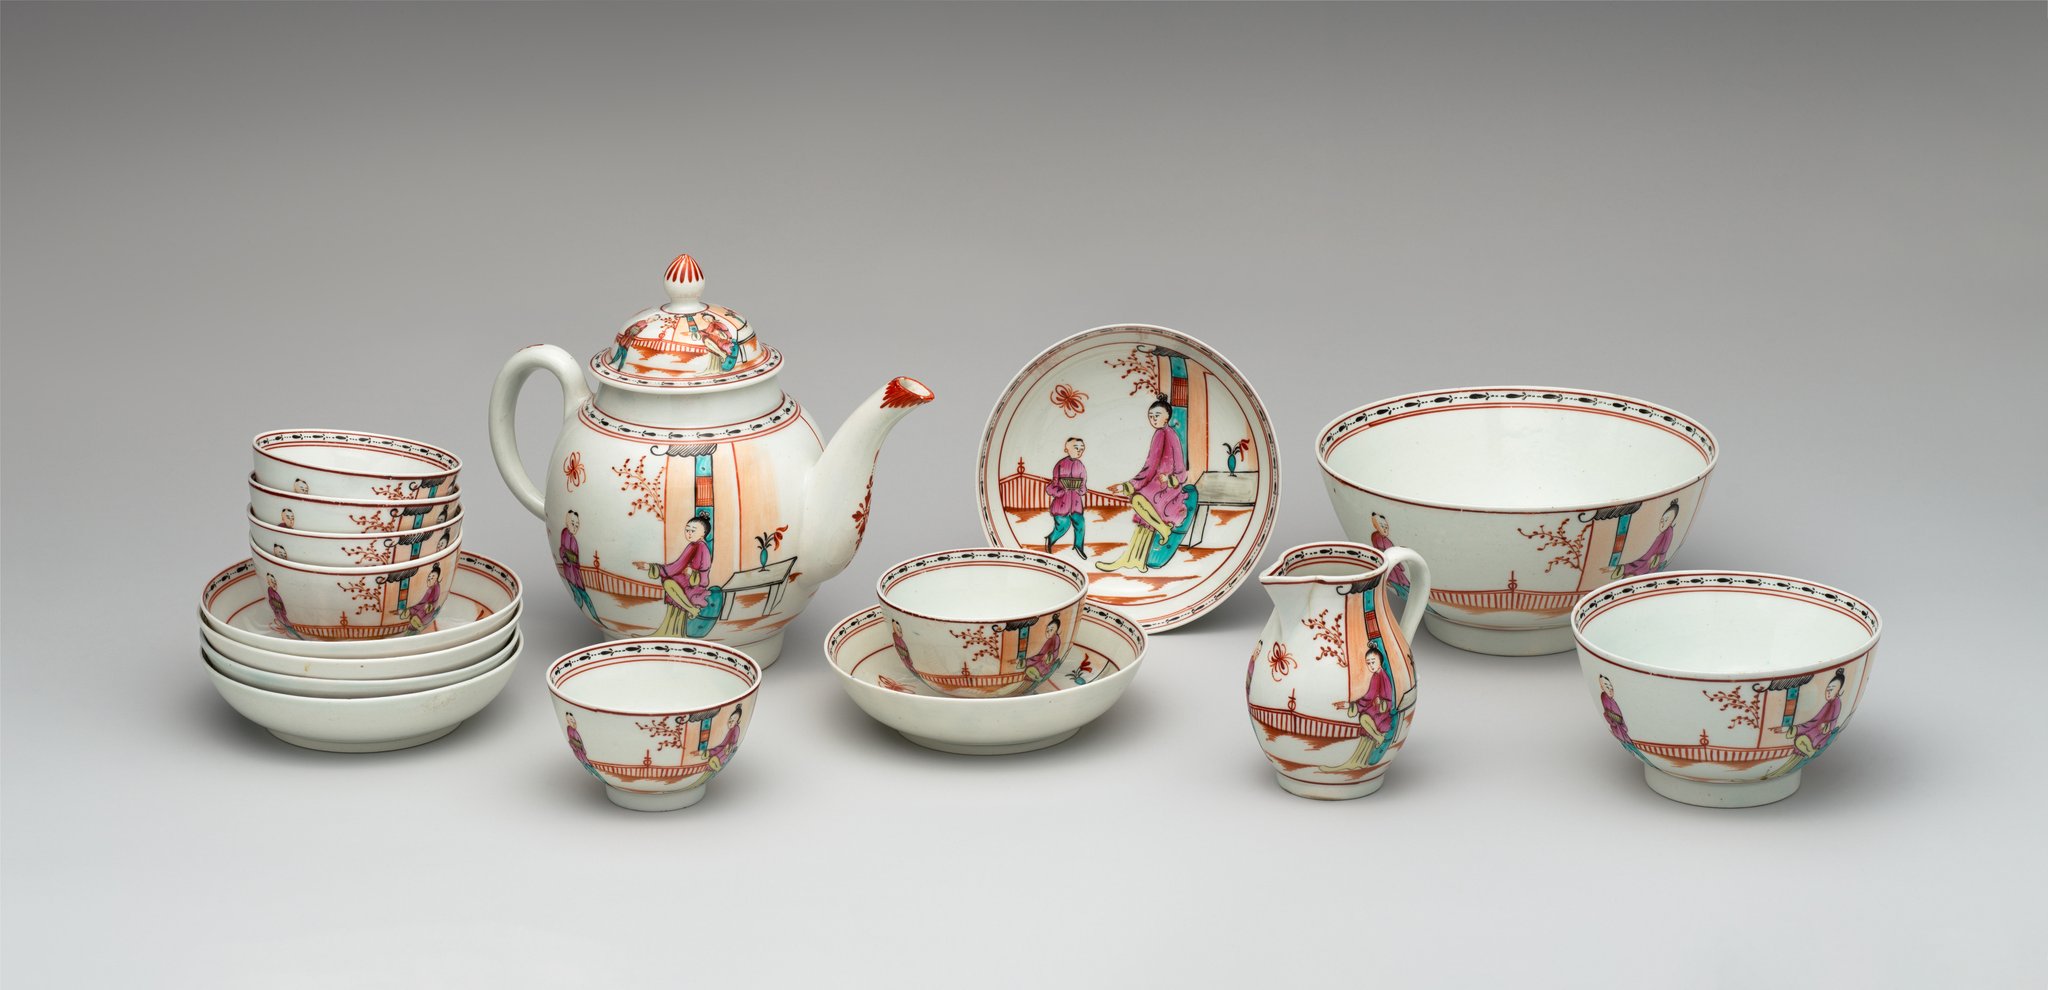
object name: tea service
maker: lowestoft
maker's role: factory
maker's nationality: british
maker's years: 1757-1803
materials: soft paste porcelain